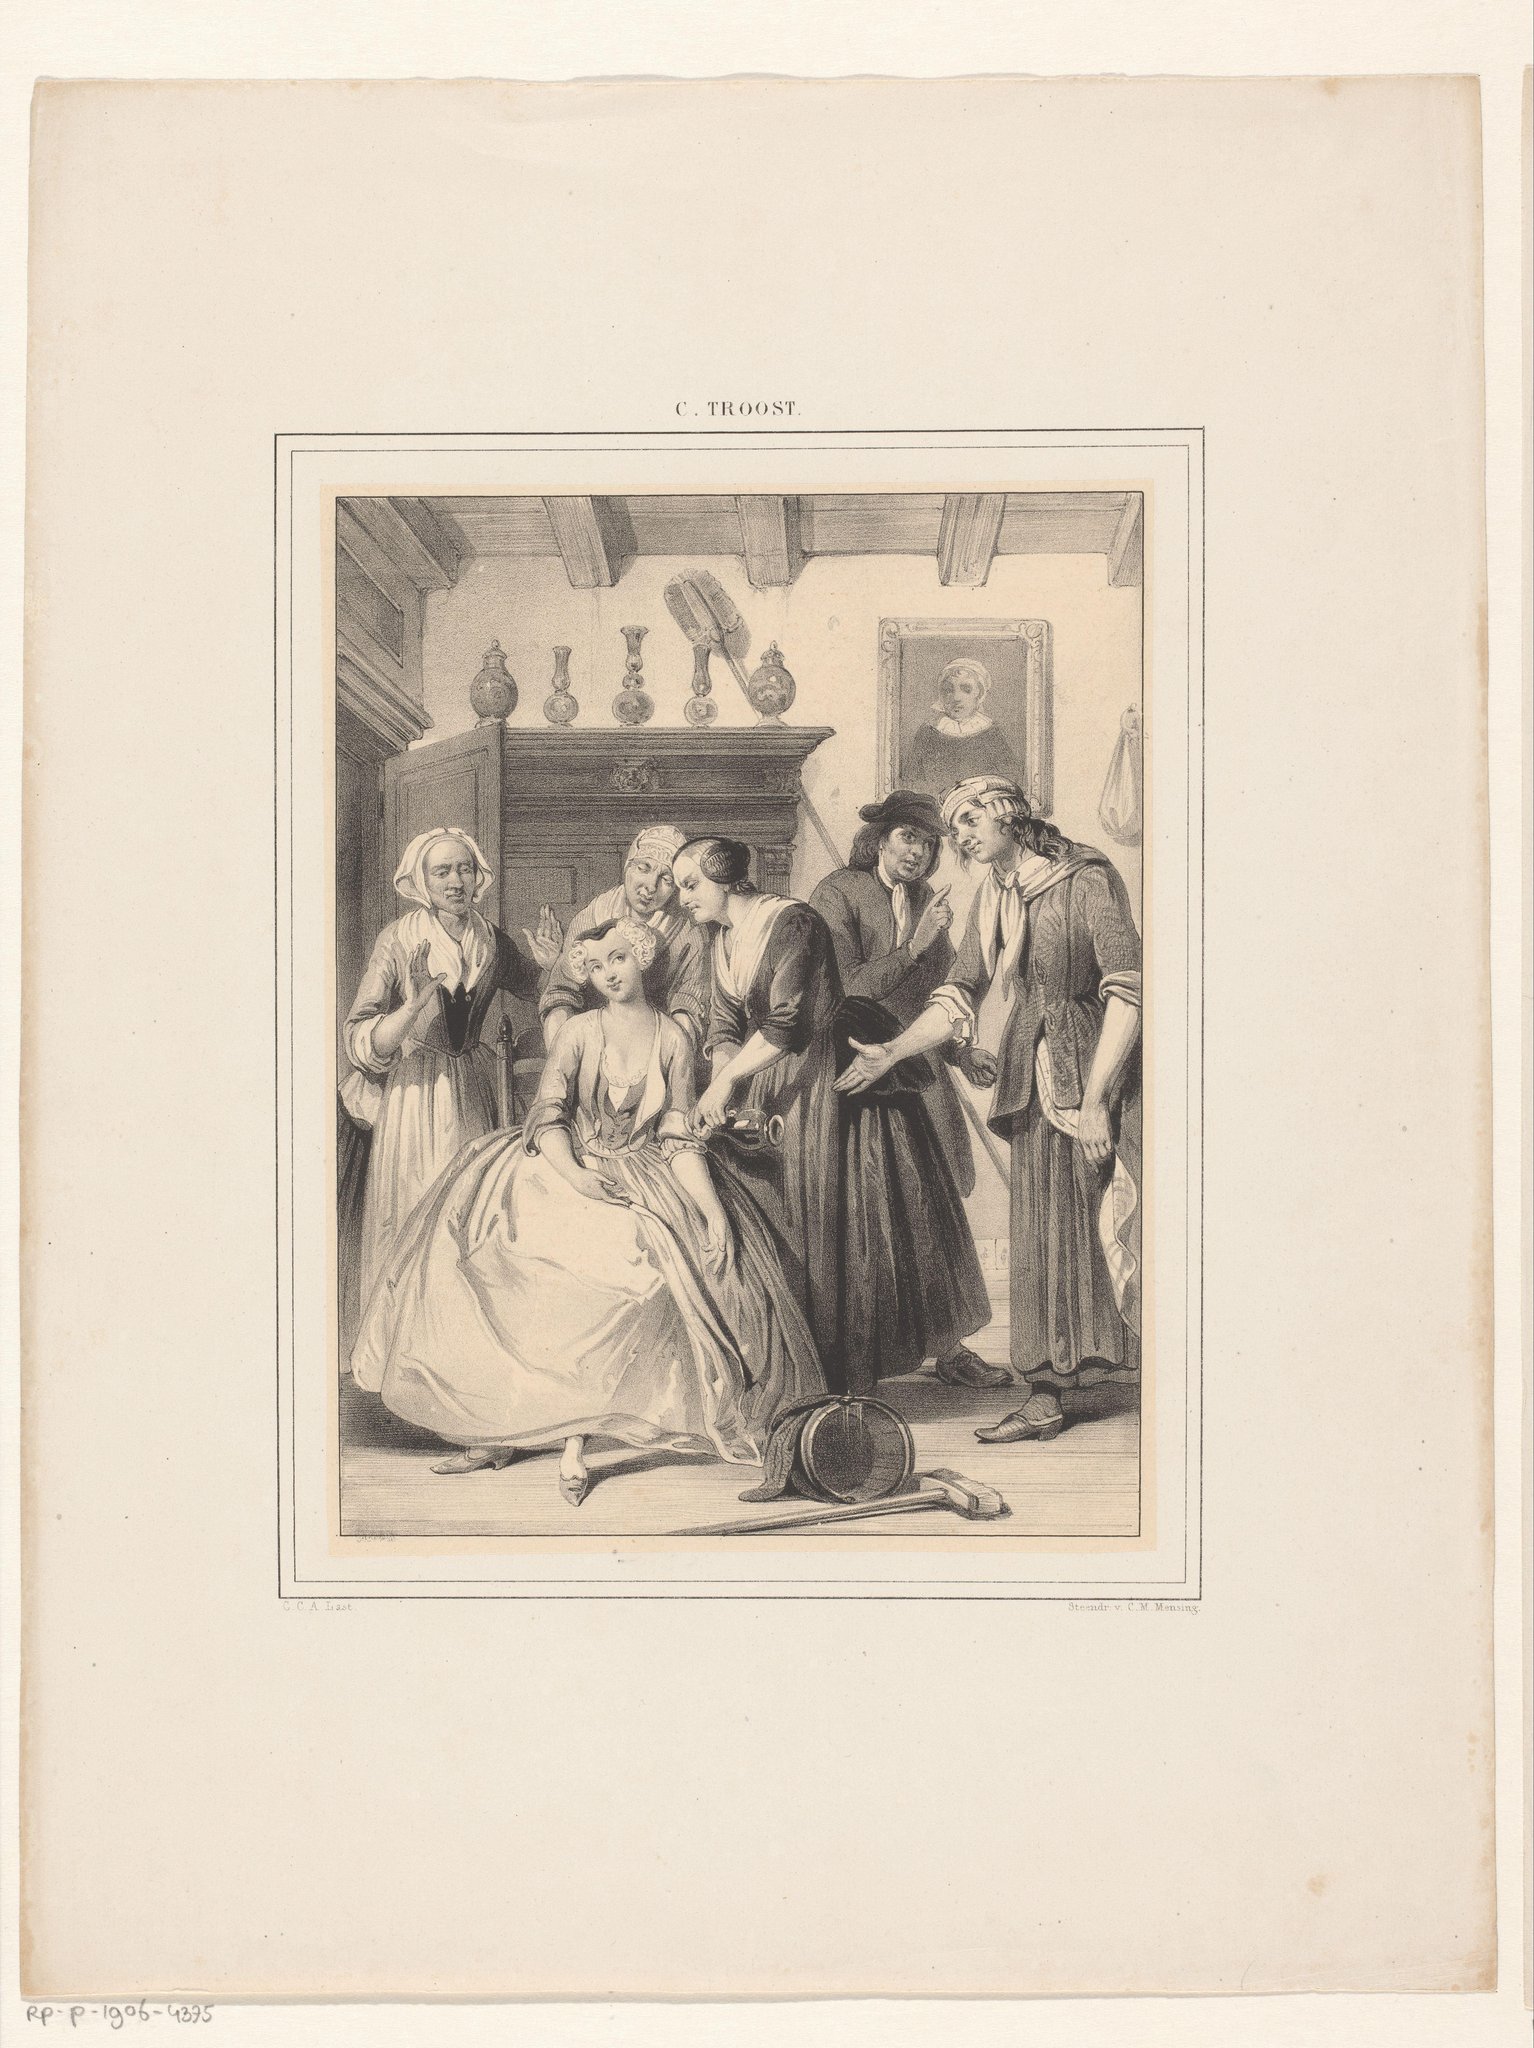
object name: print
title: Scène uit Jan Claasz of de gewaande dienstmaagd: De ontdekking van Jan Claasz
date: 1818-1876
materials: paper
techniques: lithograph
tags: man dressed as woman, travesty, fainting, swooning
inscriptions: collector's mark: Lugt 2228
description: Scène uit de comedie 'Jan Claasz. of de gewaande dienstmaagd' van Th. Asselijn. Het complot van de beide geliefden, waarbij de minnaar zich als dienstbode had verkleed, wordt door de ouders van Saartje Jans ontdekt. Om de situatie te redden veinst Saartje dat ze flauwvalt.